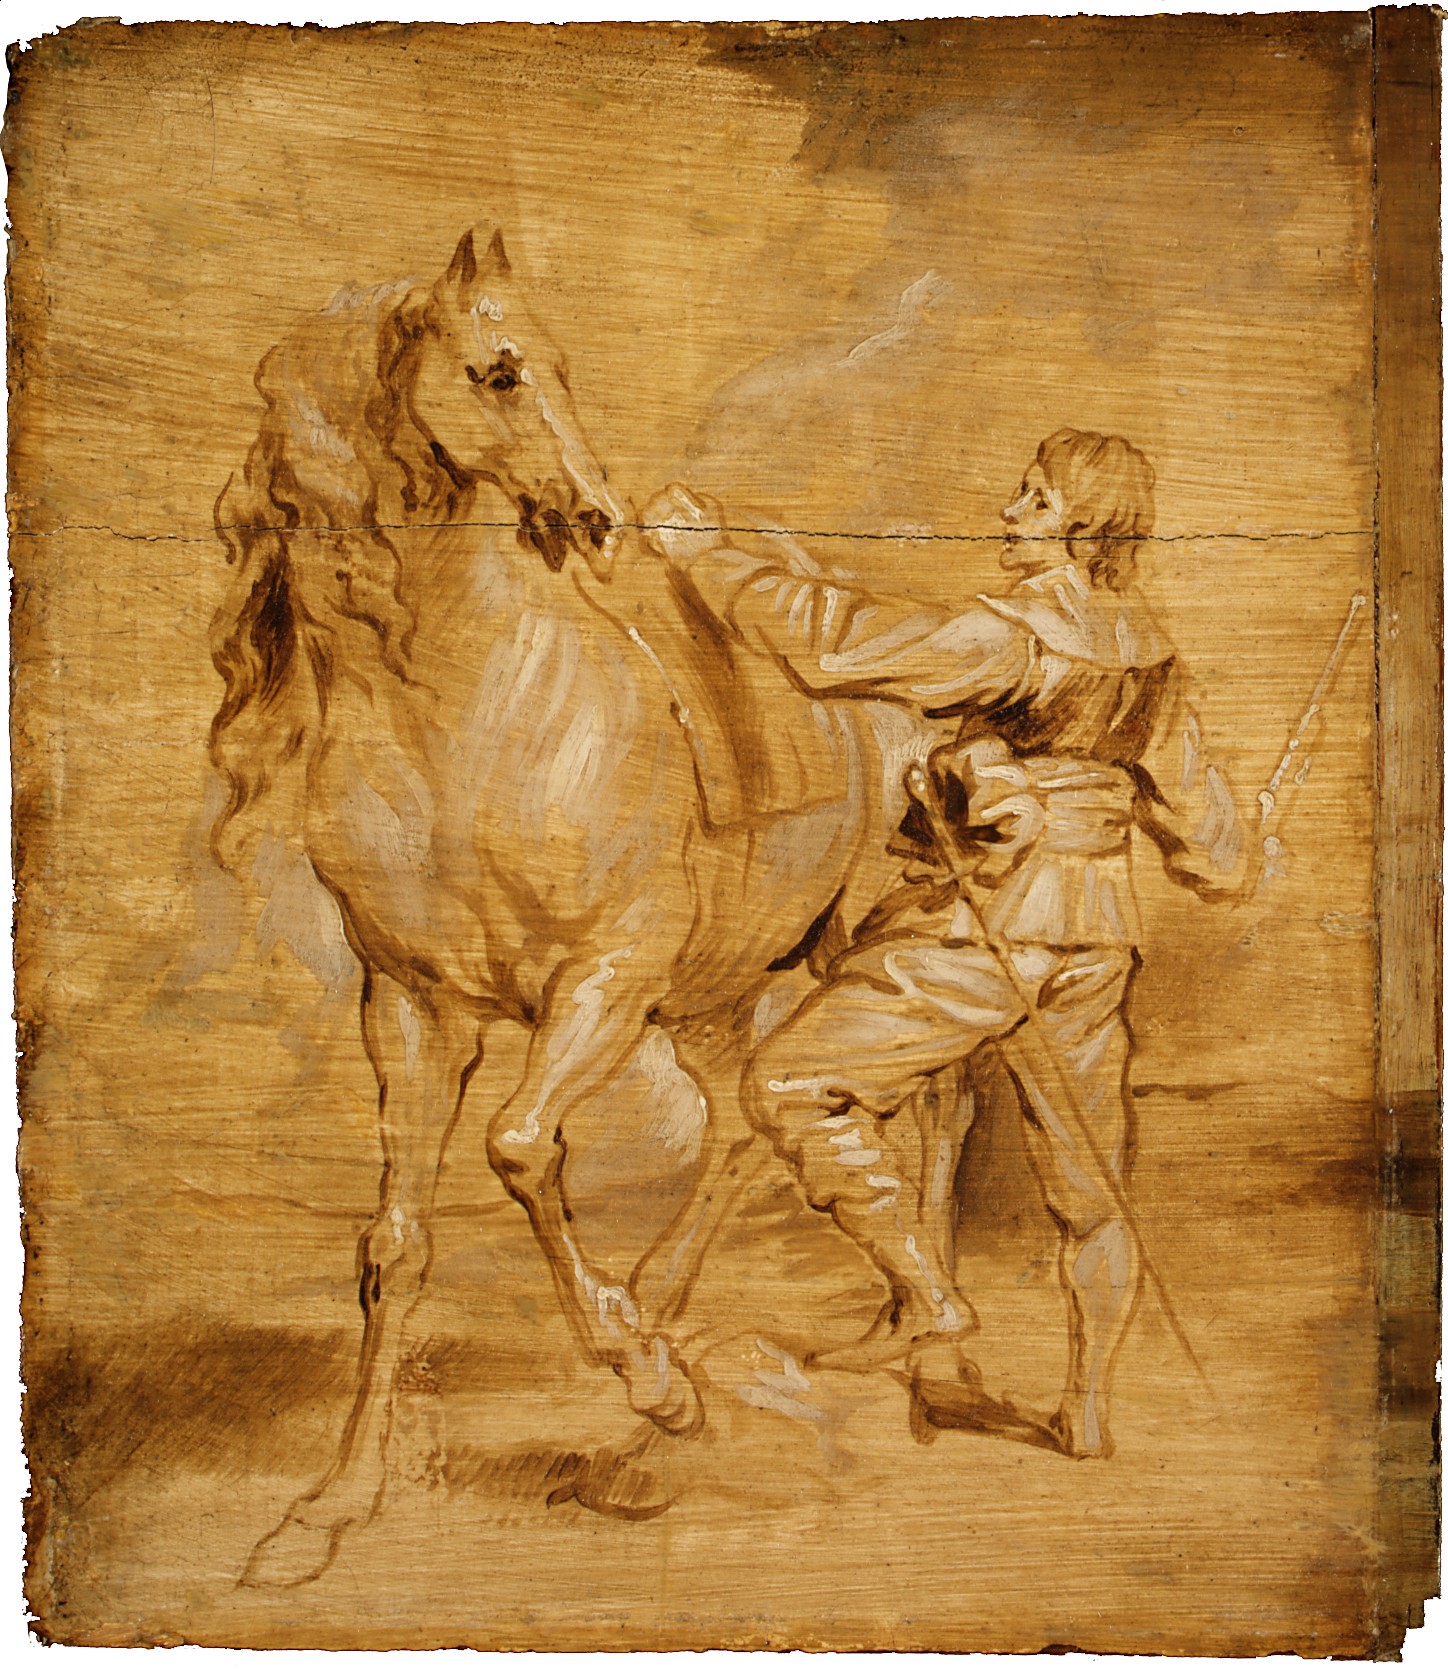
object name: painting, monochrome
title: A Man Mounting a Horse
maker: anthony van dyck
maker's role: artist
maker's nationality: flemish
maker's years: 1599-1641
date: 1630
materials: oil, wood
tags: men,horses